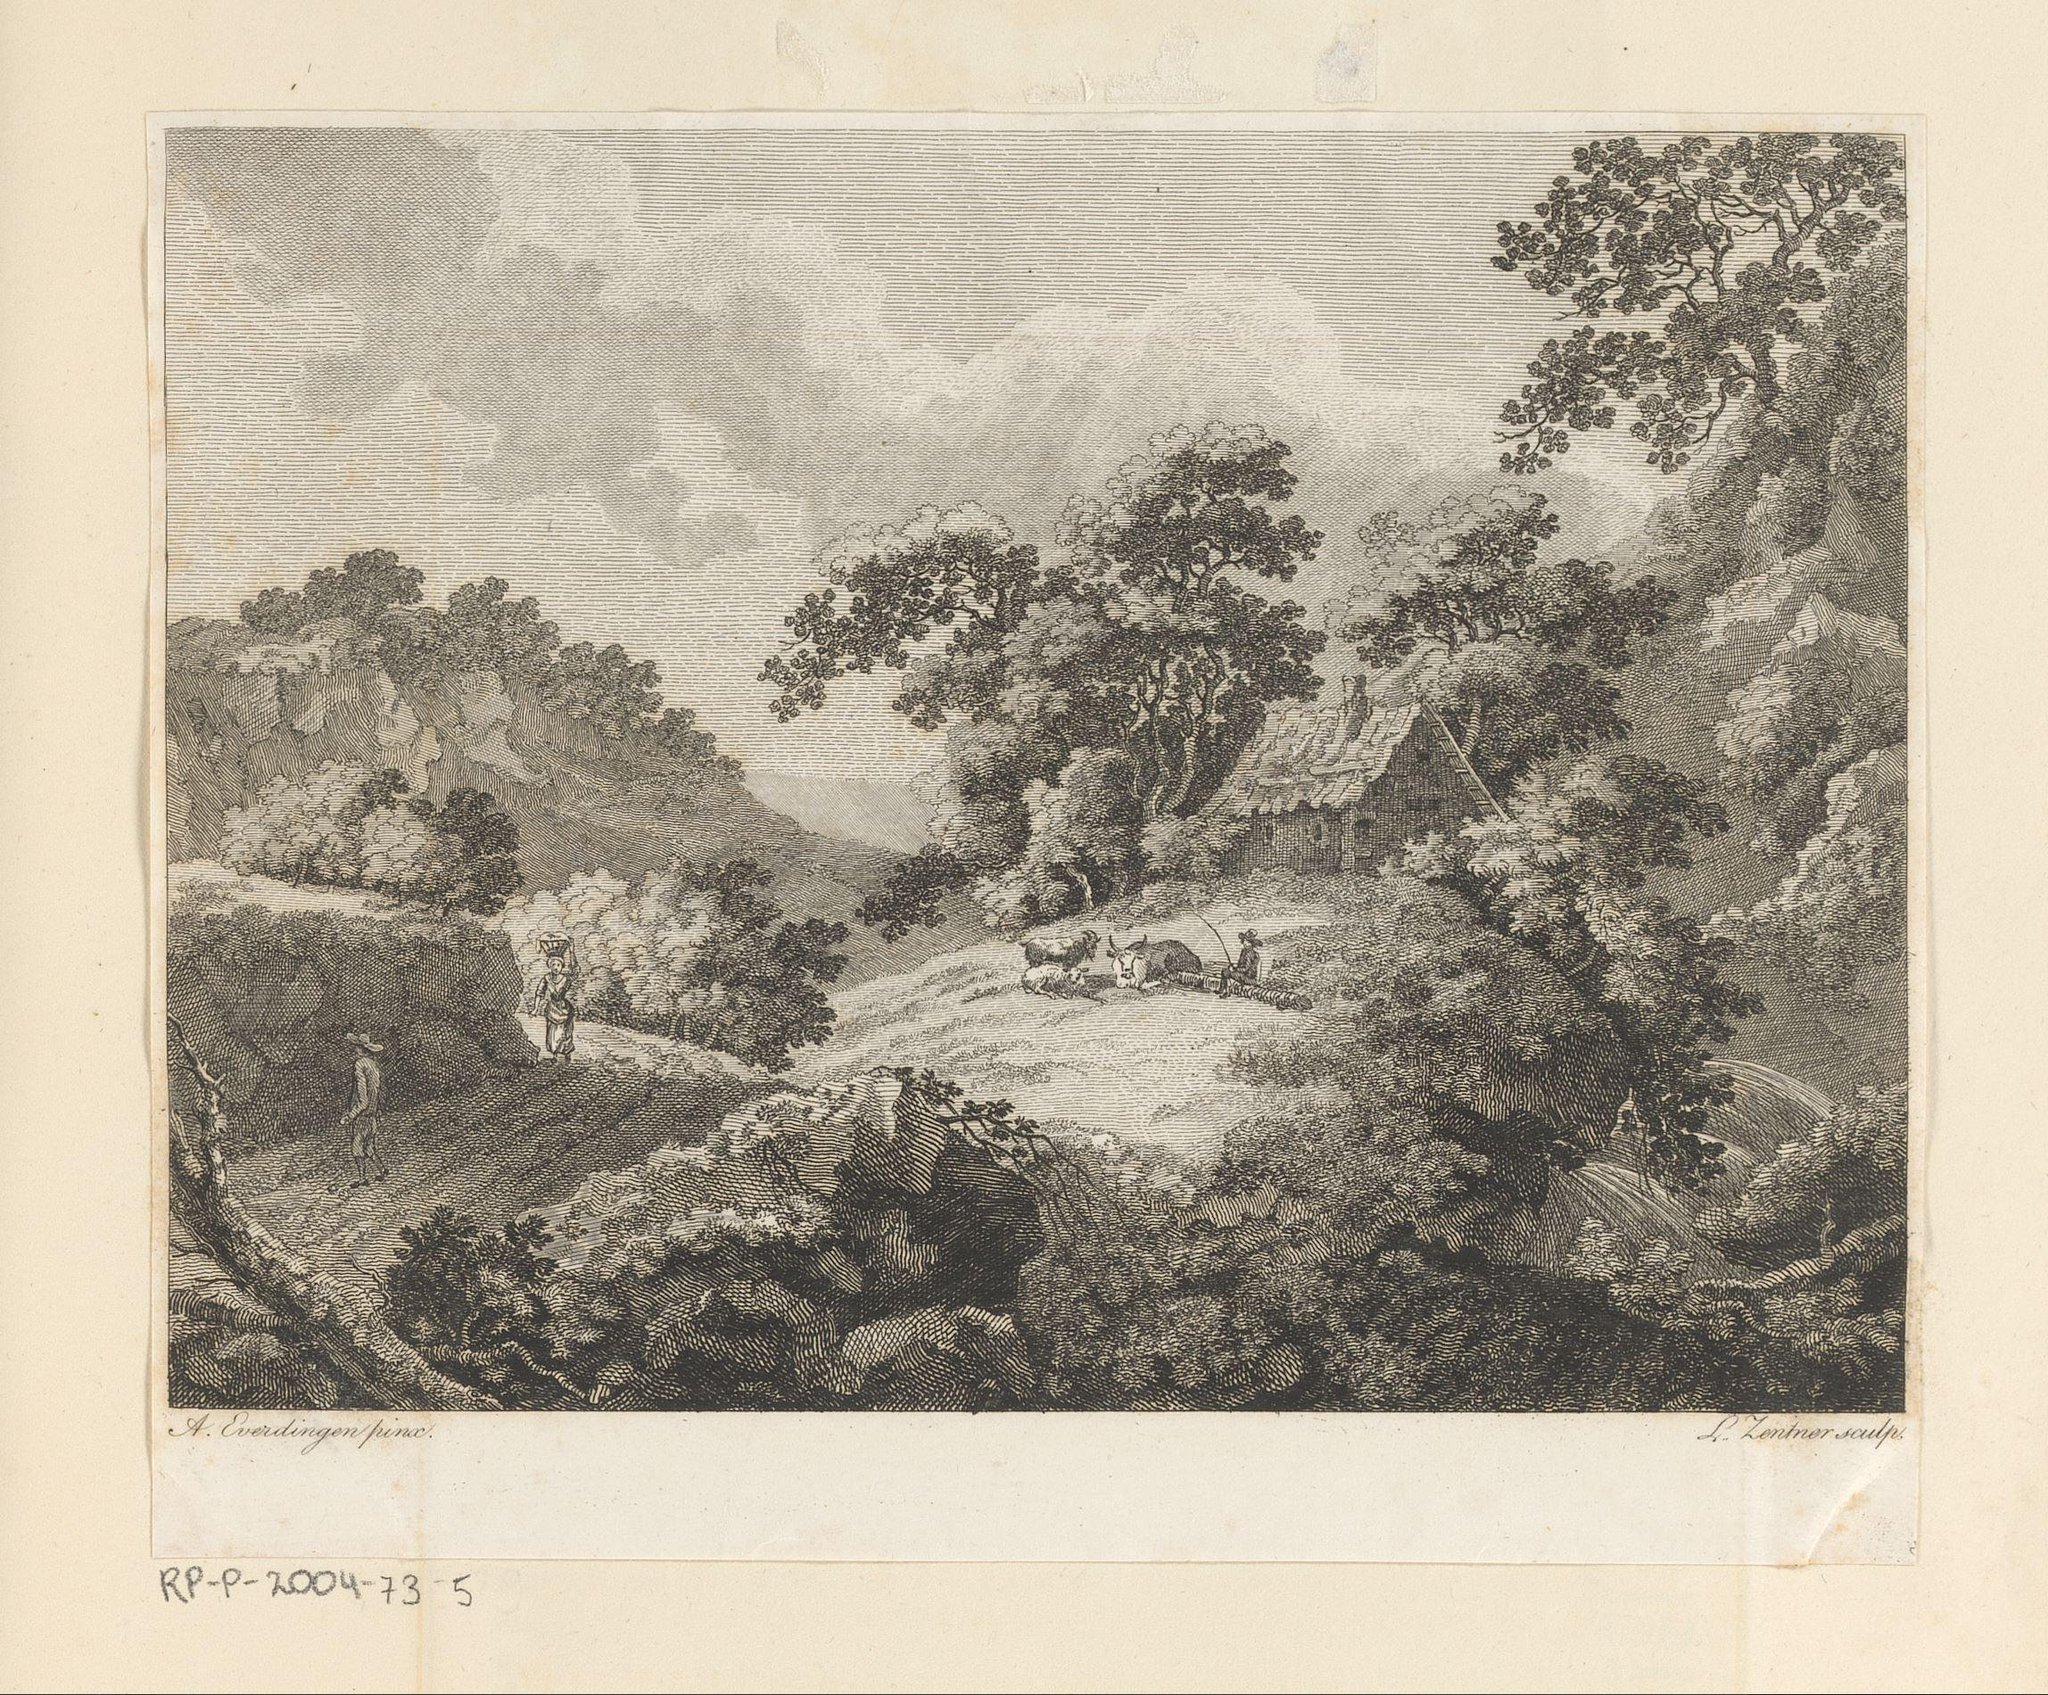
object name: album leaf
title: Heuvelachtig landschap met vee en figuren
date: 1791-1798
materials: paper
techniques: engraving, etching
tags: low hill country (+ landscape with figures, staffage)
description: Prent uit: Zentner, J.L.L.C.. A select Collection of landscapes, from the best old masters, one of each engraved by L. Zentner, after drawings made by him from original pictures (...). Londen: J. Thane, [1791-1798]. De samensteller heeft deze prent in het album geplakt als illustratie bij: Pilkington, Matthew en Johann Heinrich Füssli. A dictionary of painters, from the revival of the art to the present period. 4 dln. Londen: John Crowder, 1805, dl. 2, p. 178.